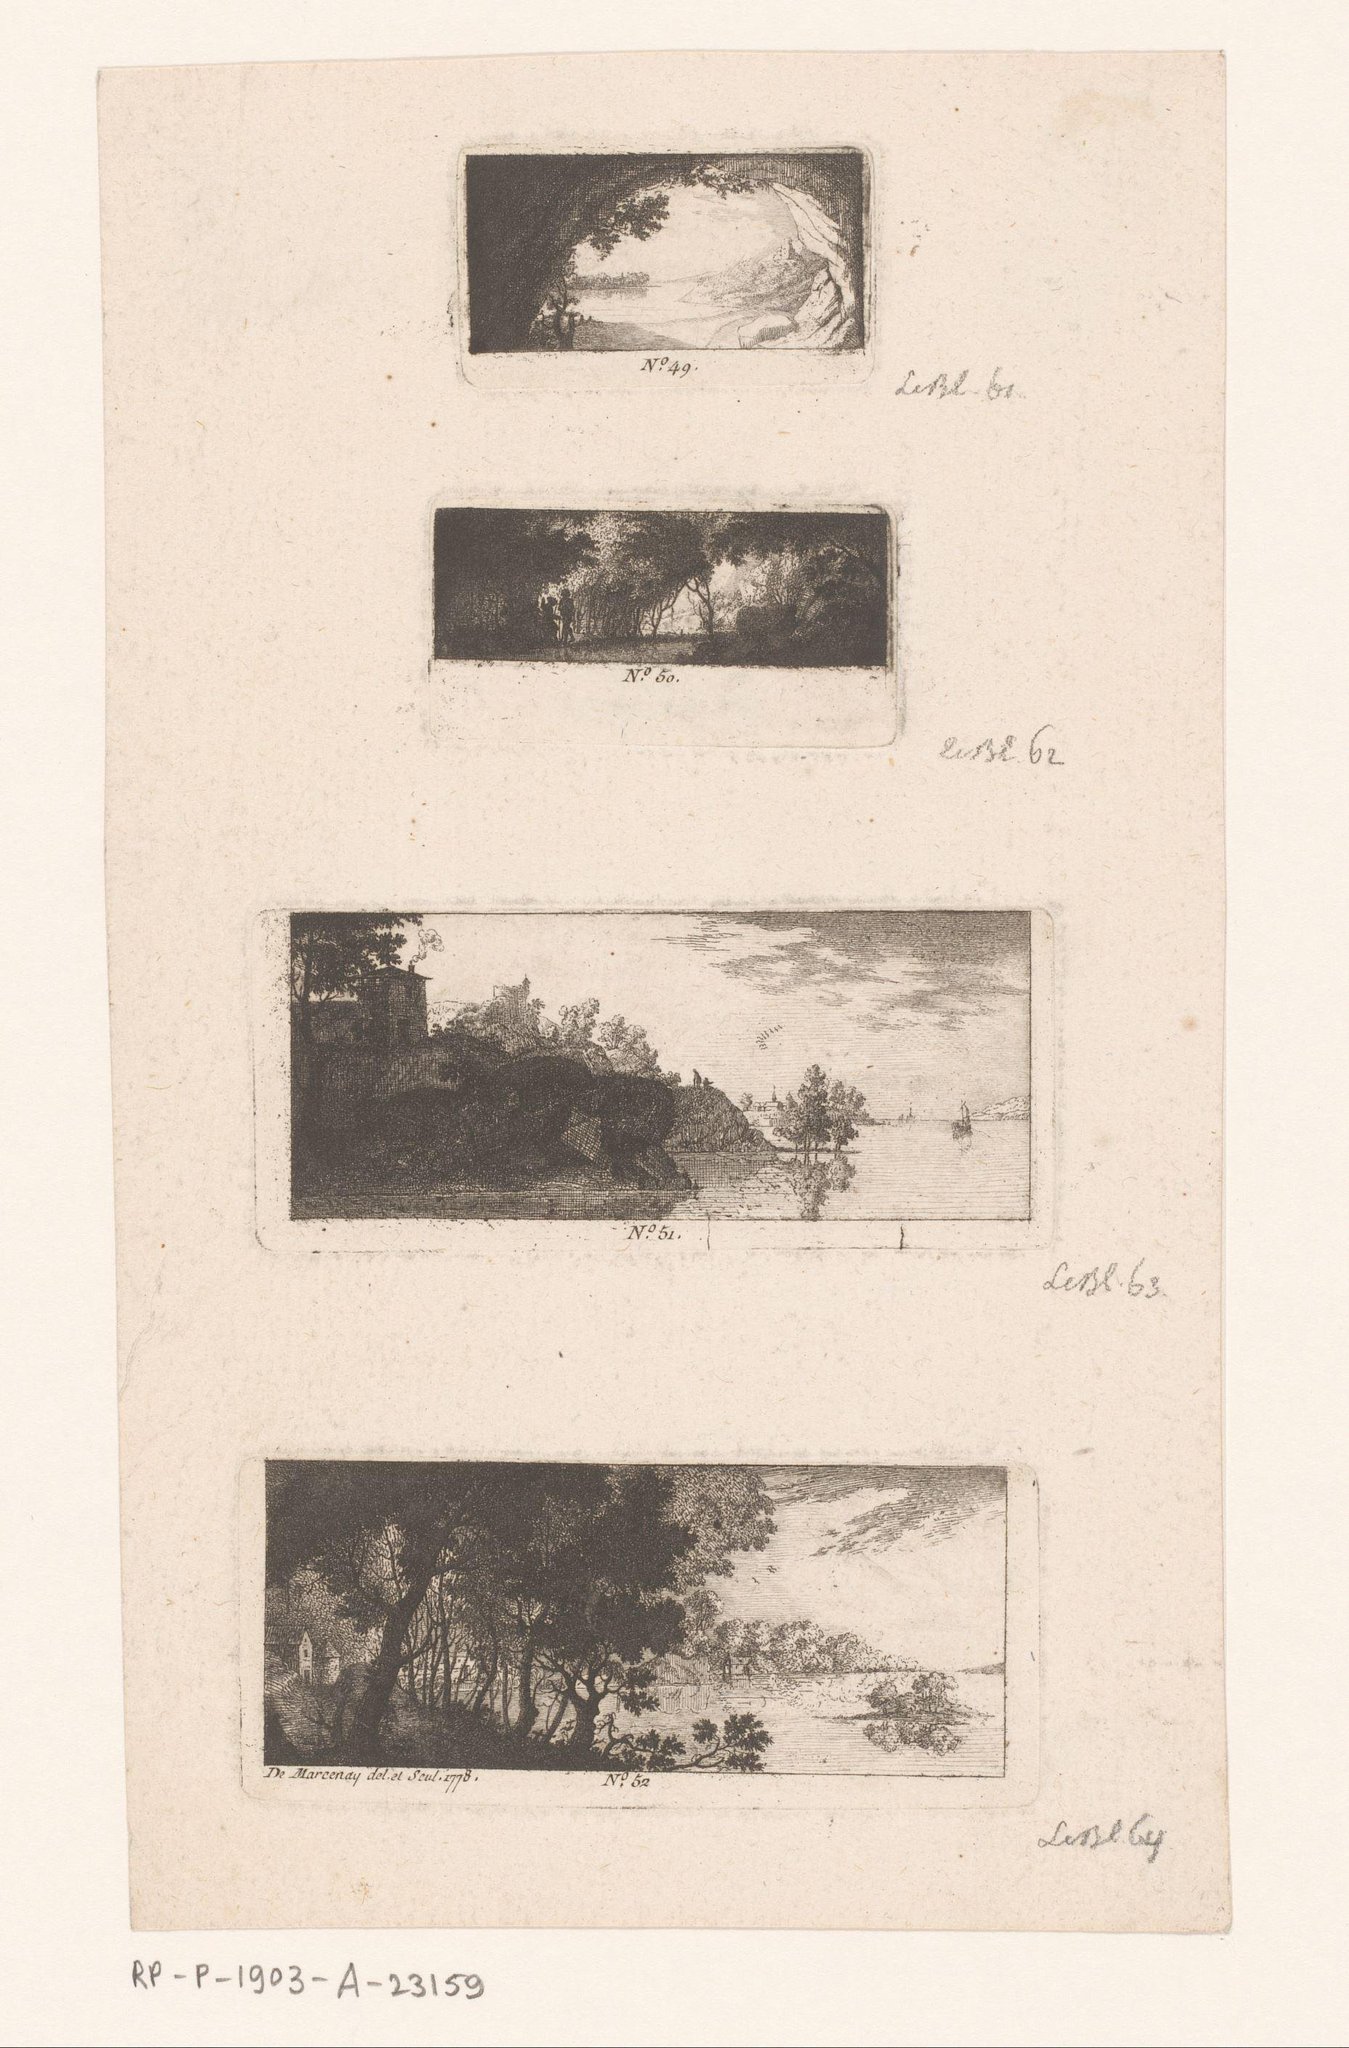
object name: print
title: Drie rivierlandschappen en een bosgezicht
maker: antoine de marcenay de ghuy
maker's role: print maker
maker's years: 1724-1811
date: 1734-1811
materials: paper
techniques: etching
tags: river, forest, wood, cave, grotto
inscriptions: collector's mark: Lugt 2228